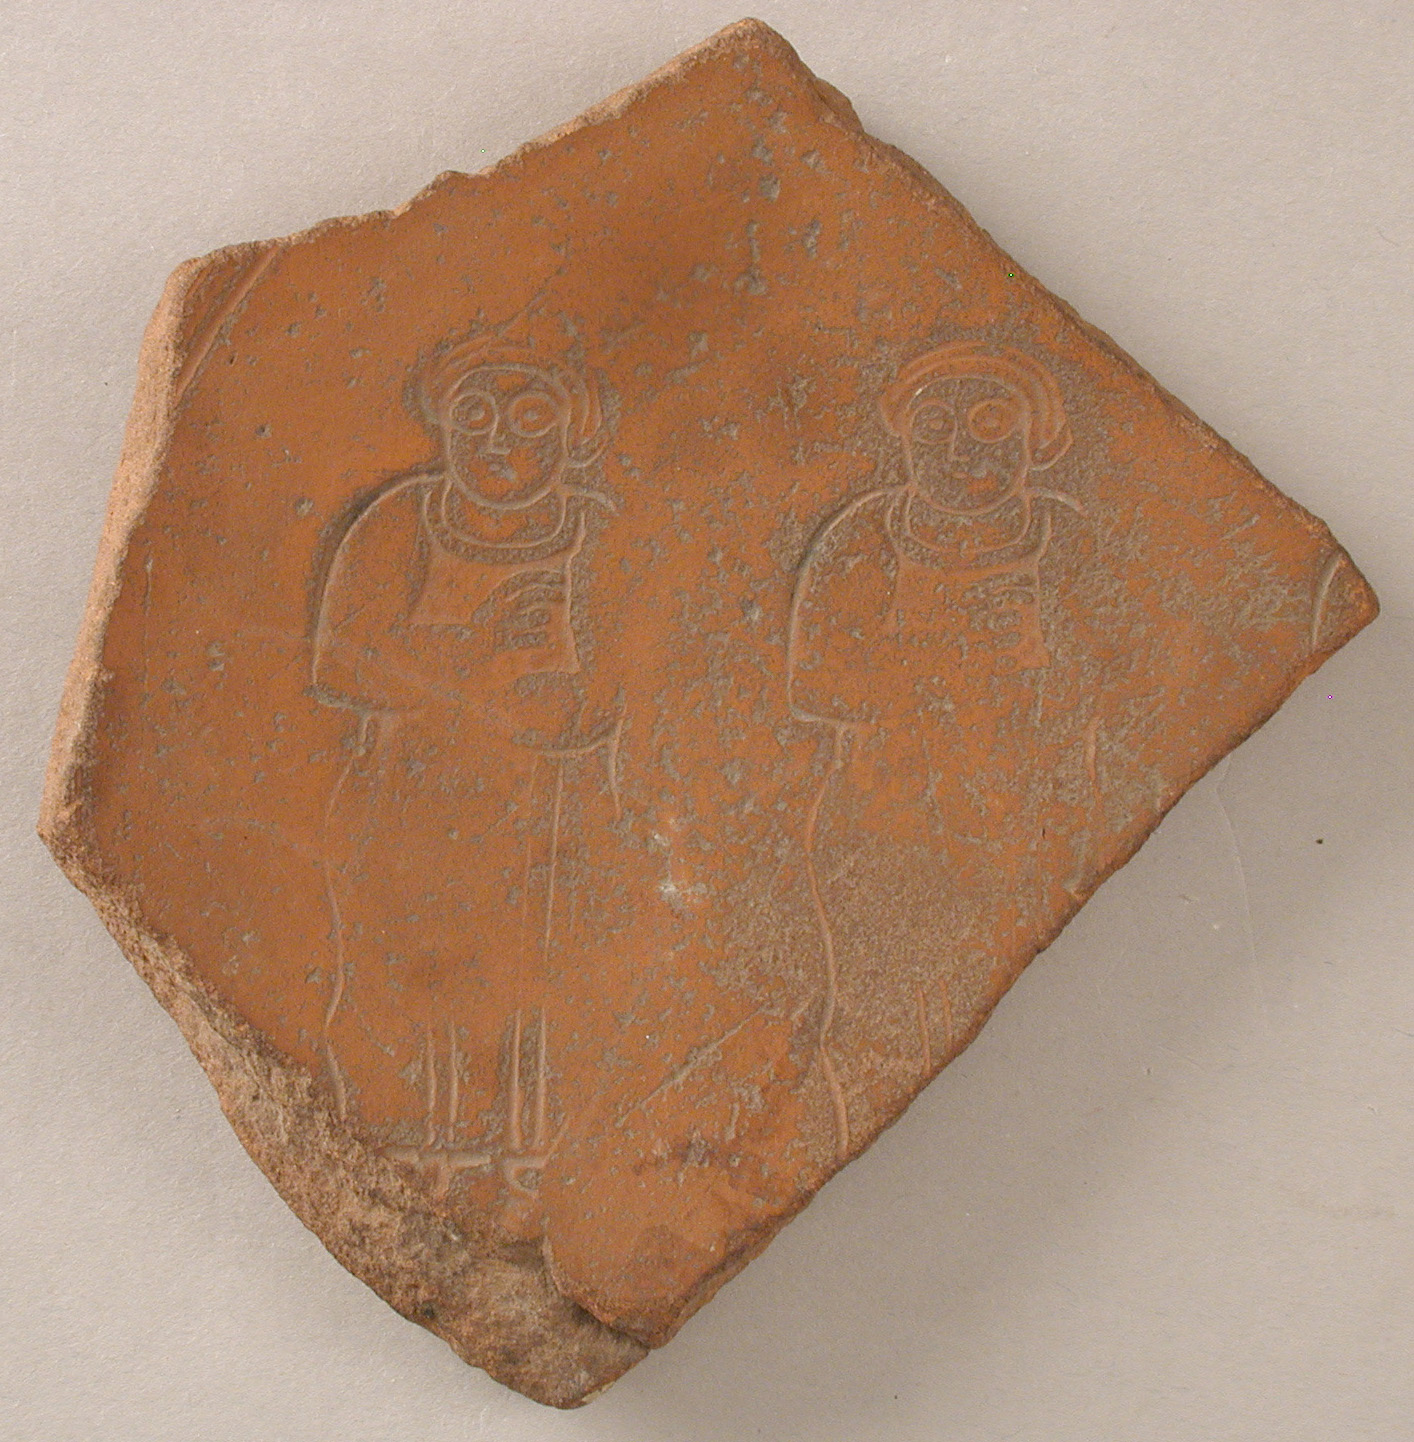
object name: fragment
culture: byzantine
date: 401-600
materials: earthenware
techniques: stamping